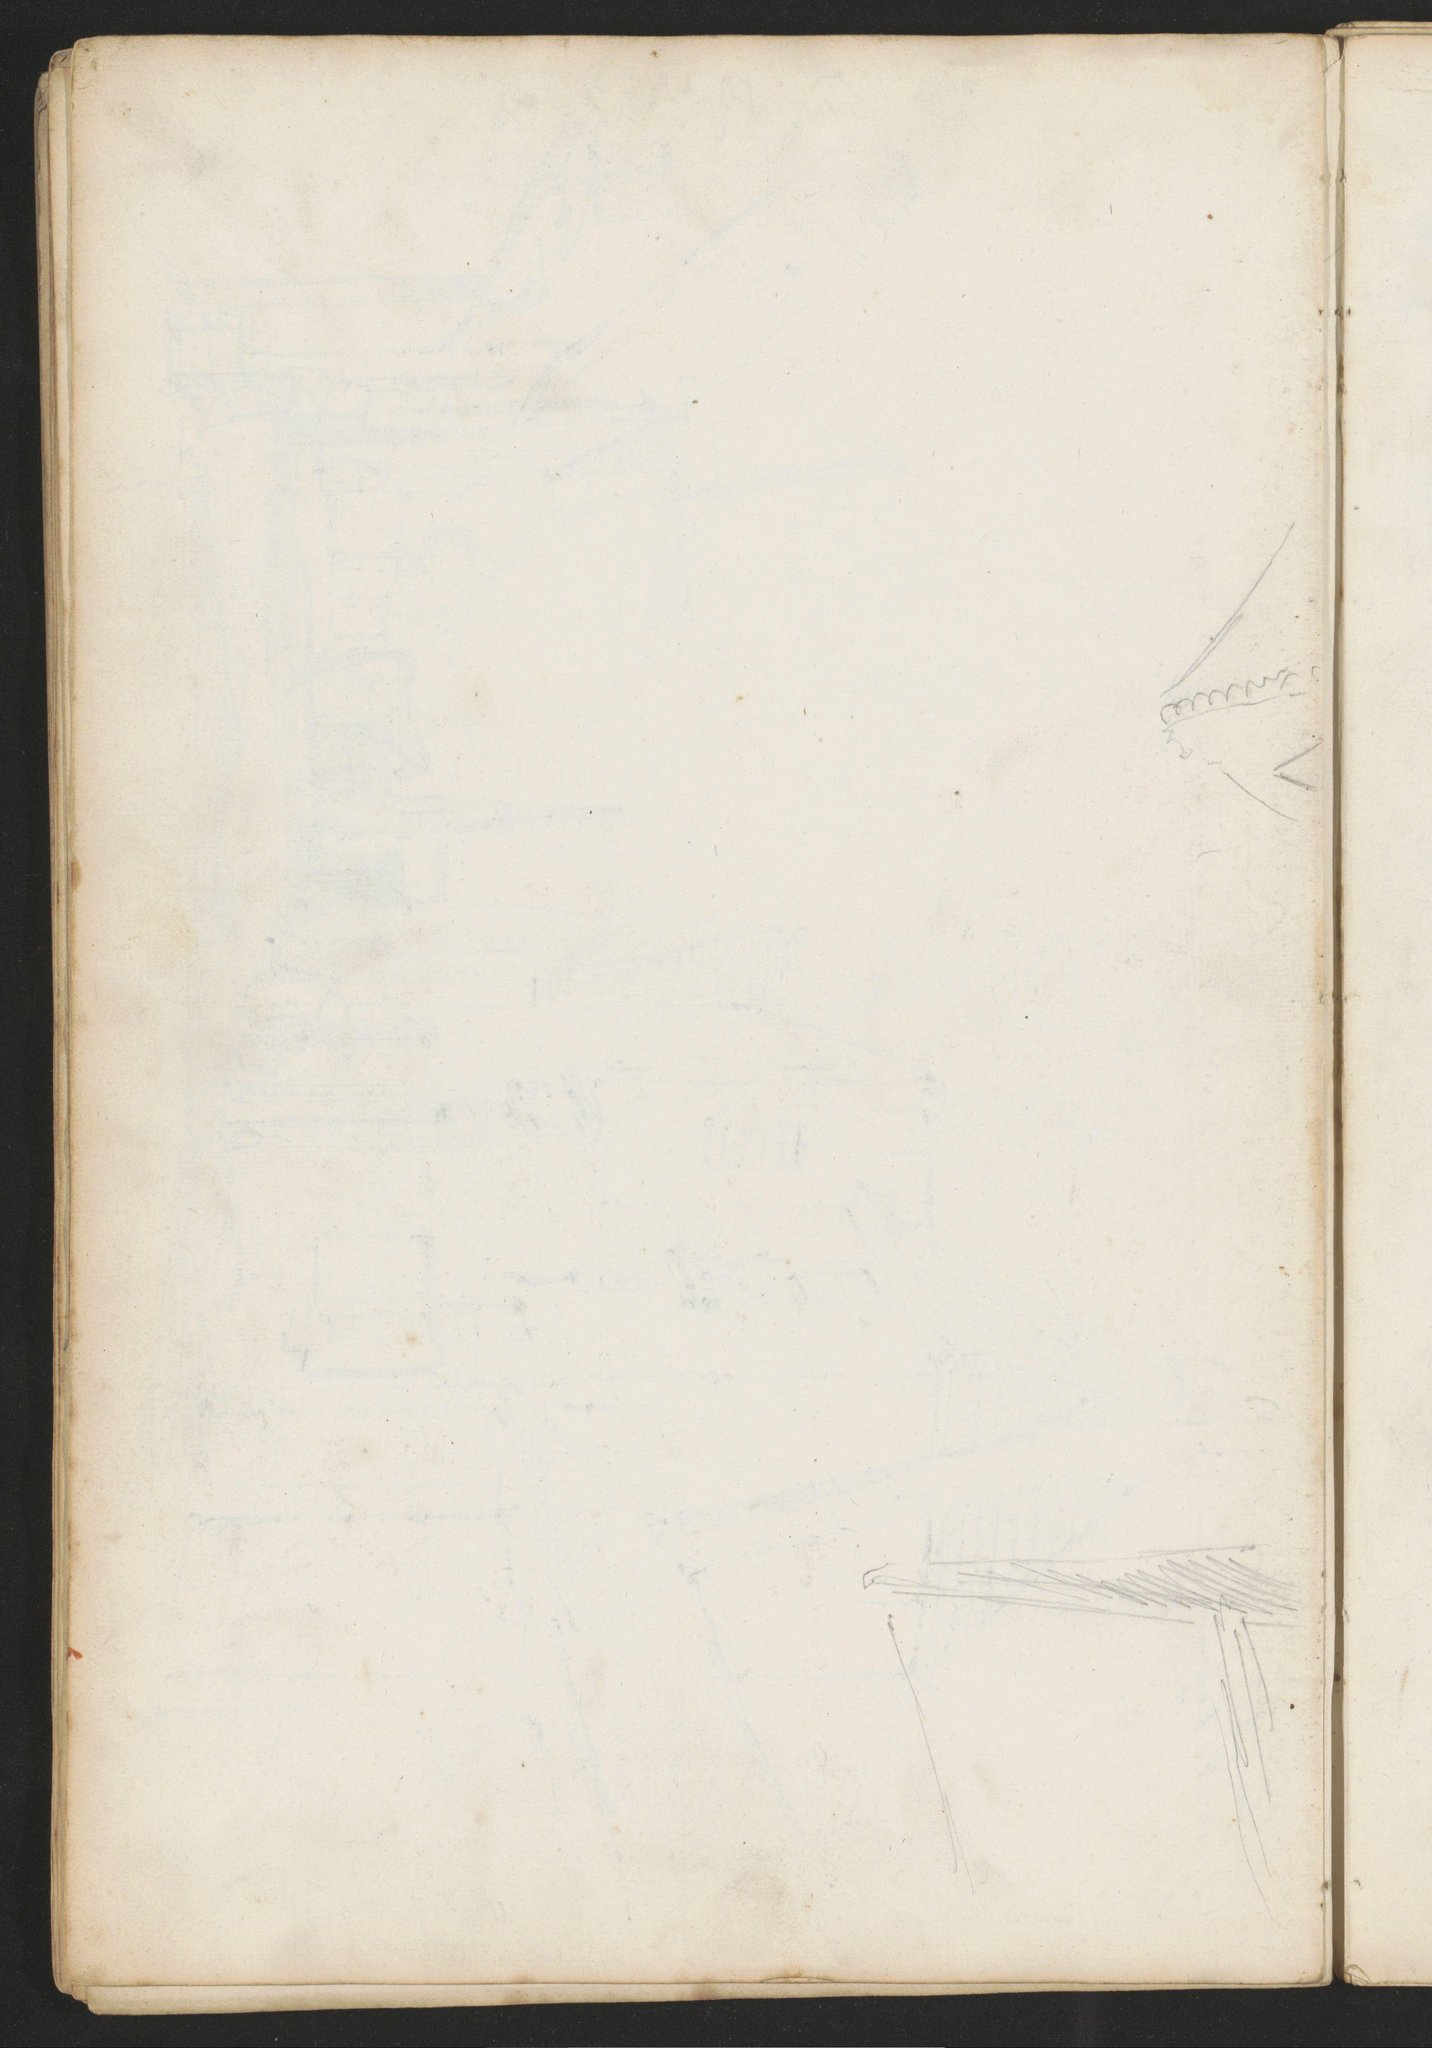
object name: sketchbook leaf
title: Studies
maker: willem koekkoek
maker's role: draughtsman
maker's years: 1839-1895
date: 1849-1895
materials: paper, pencil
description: Blad 20 verso uit een schetsboek met 42 bladen.